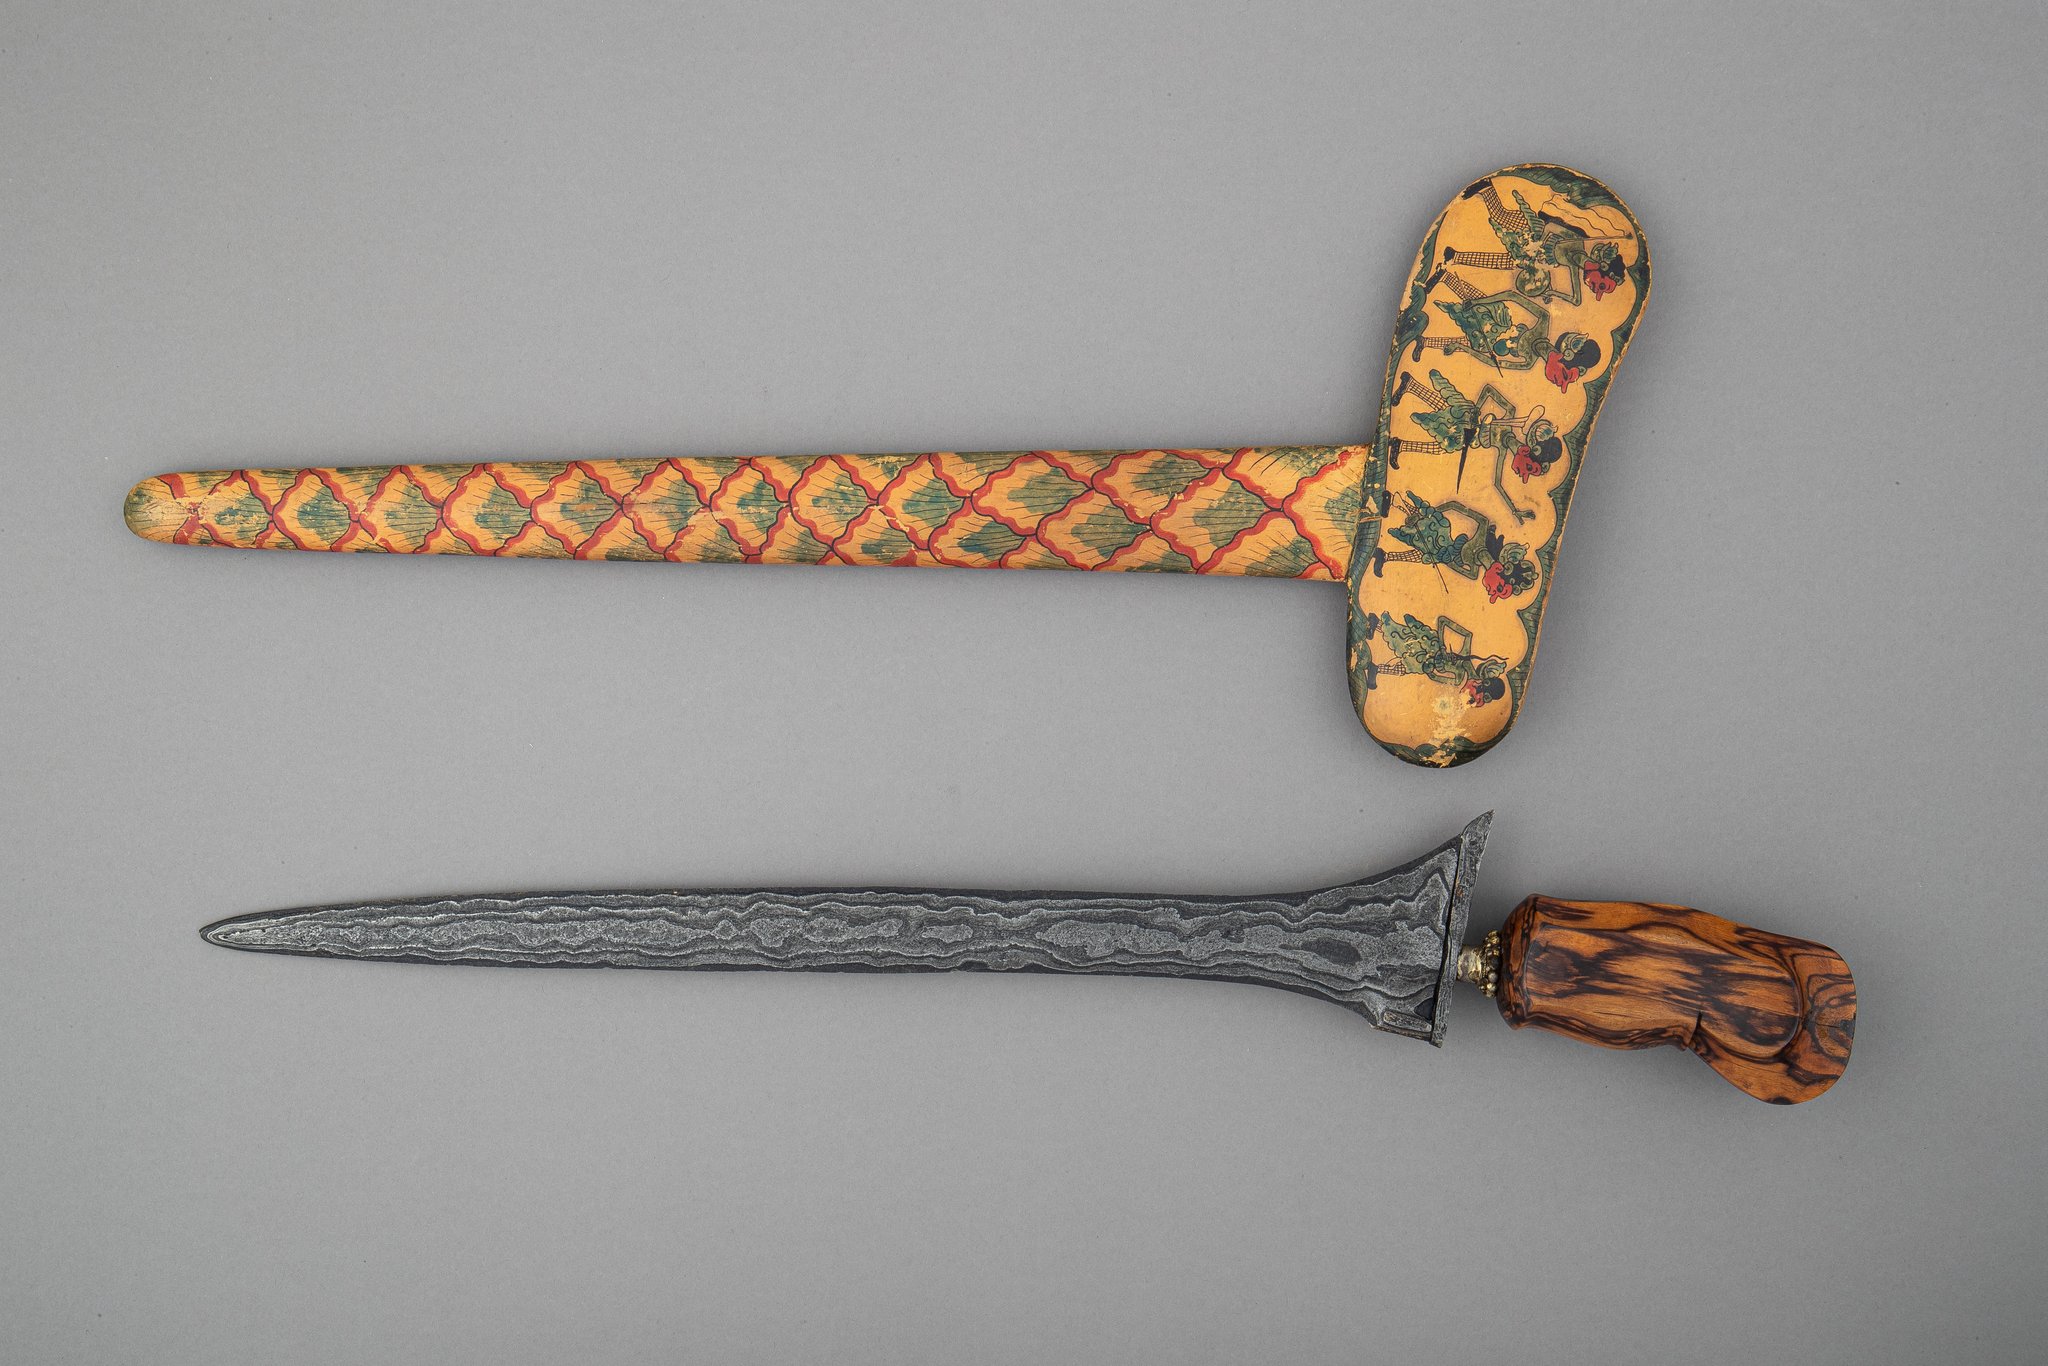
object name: kris with sheath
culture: balinese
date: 1501-1900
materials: copper alloy, pigment, steel, wood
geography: indonesia